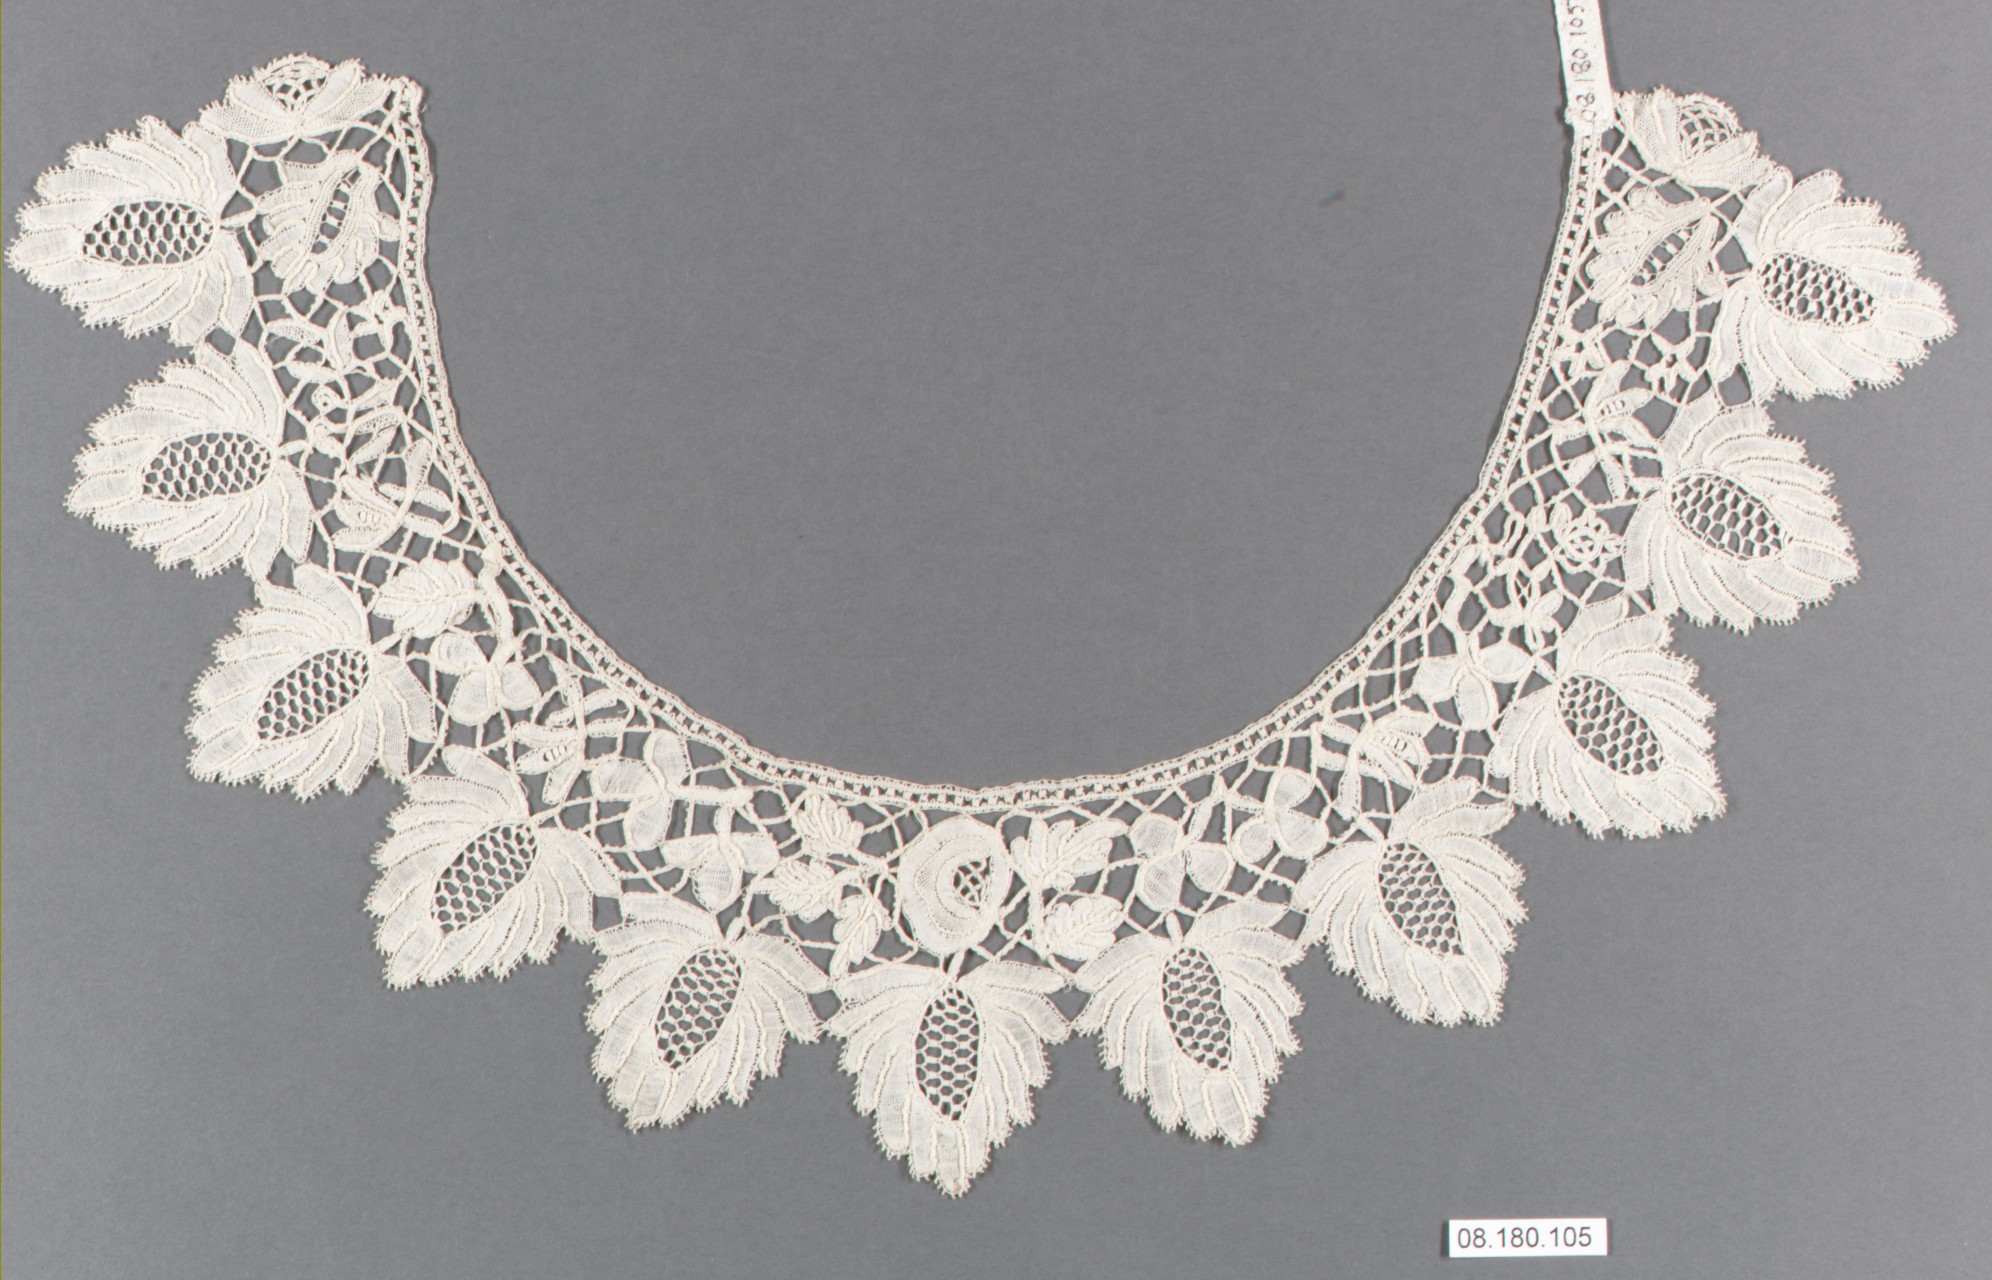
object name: collar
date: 1801-1900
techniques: lace